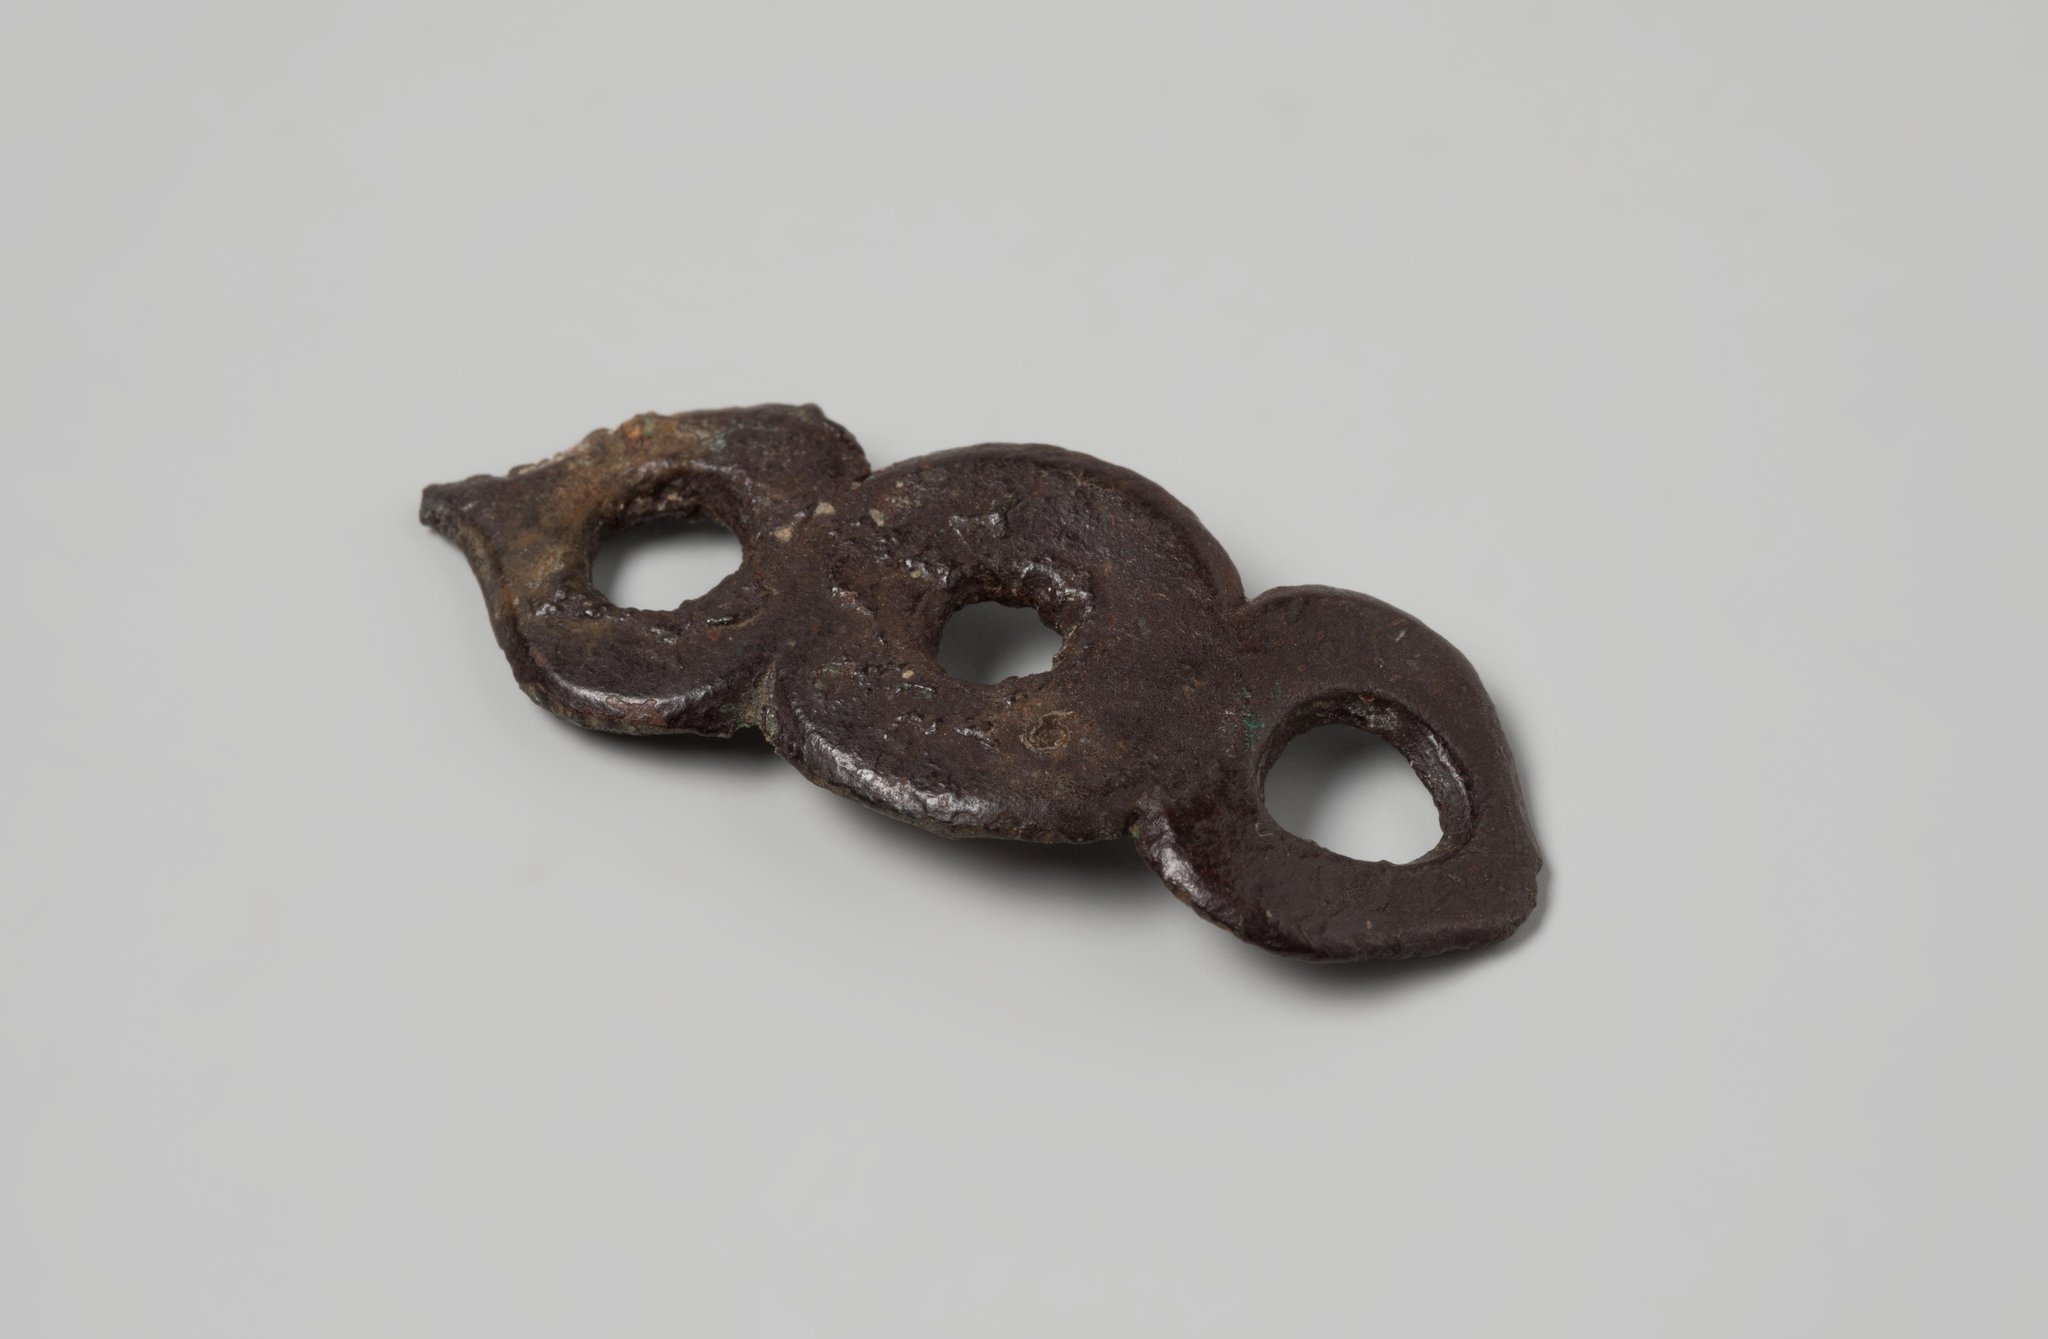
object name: beslag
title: Decoratief beslag uit het wrak van de Oost-Indiëvaarder Hollandia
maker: Anonymous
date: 1700-1743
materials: copper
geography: netherlands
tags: verenigde oostindische compagnie, hollandia (schip), annet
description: Fitting, decorative fitting or fragment; slightly bent, oblong, wavy outline, pointed ends, 3 circular holes along centre.